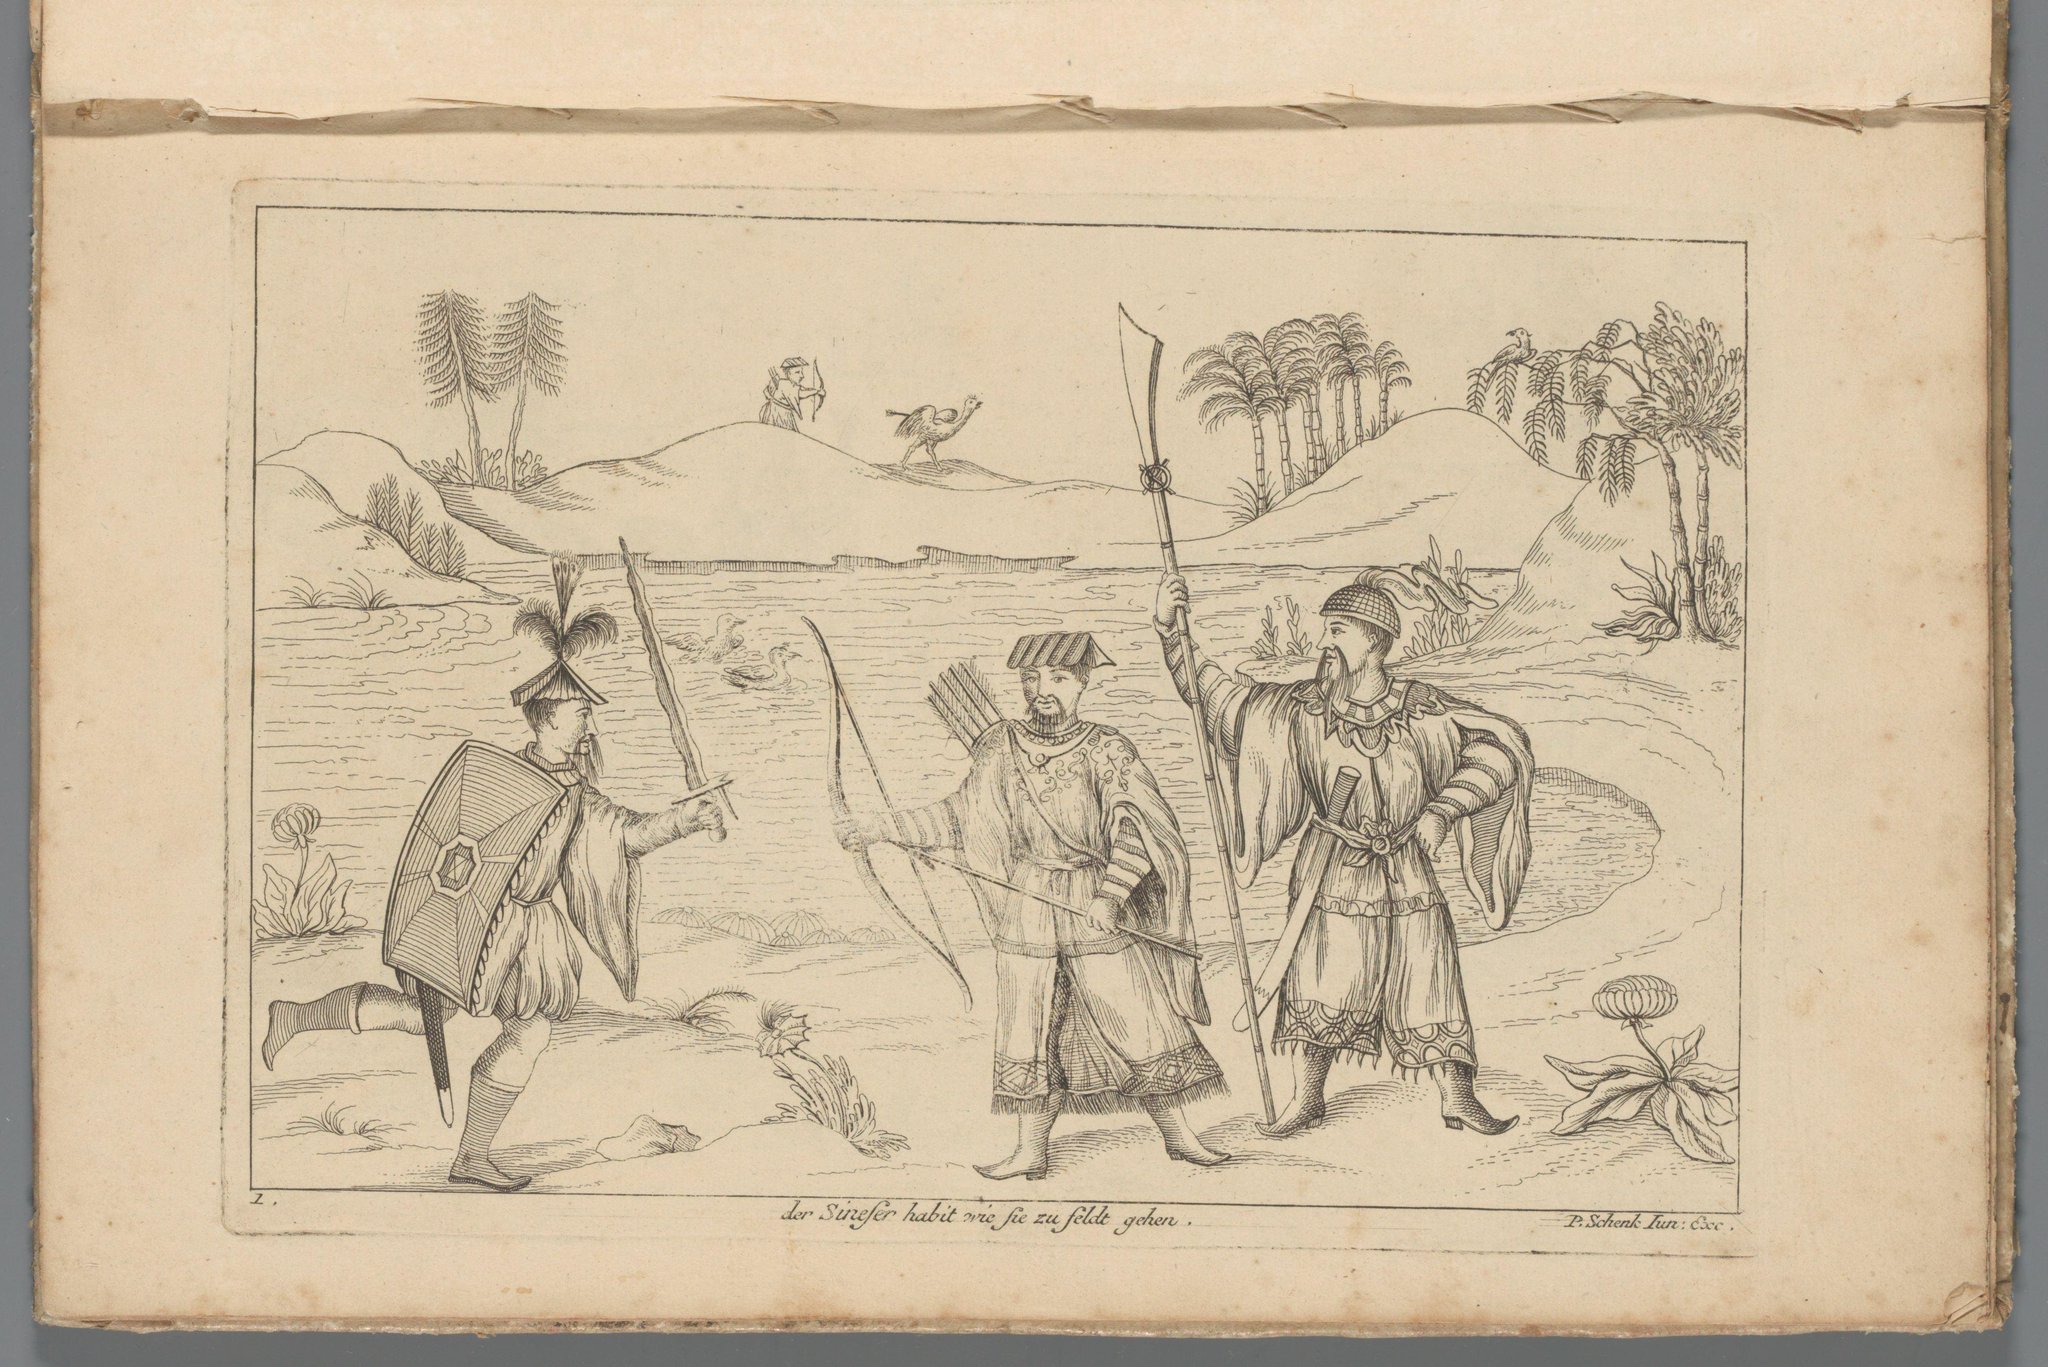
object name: album leaf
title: Drie Chinese strijders in een landschap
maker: pieter schenk (ii)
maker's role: draughtsman, print maker, publisher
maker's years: 1693-1775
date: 1727-1775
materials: paper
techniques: etching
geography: amsterdam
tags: chinese, landscapes in the temperate zone, weapons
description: Drie Chinese strijders in een landschap. Prent maakt deel uit van een album.